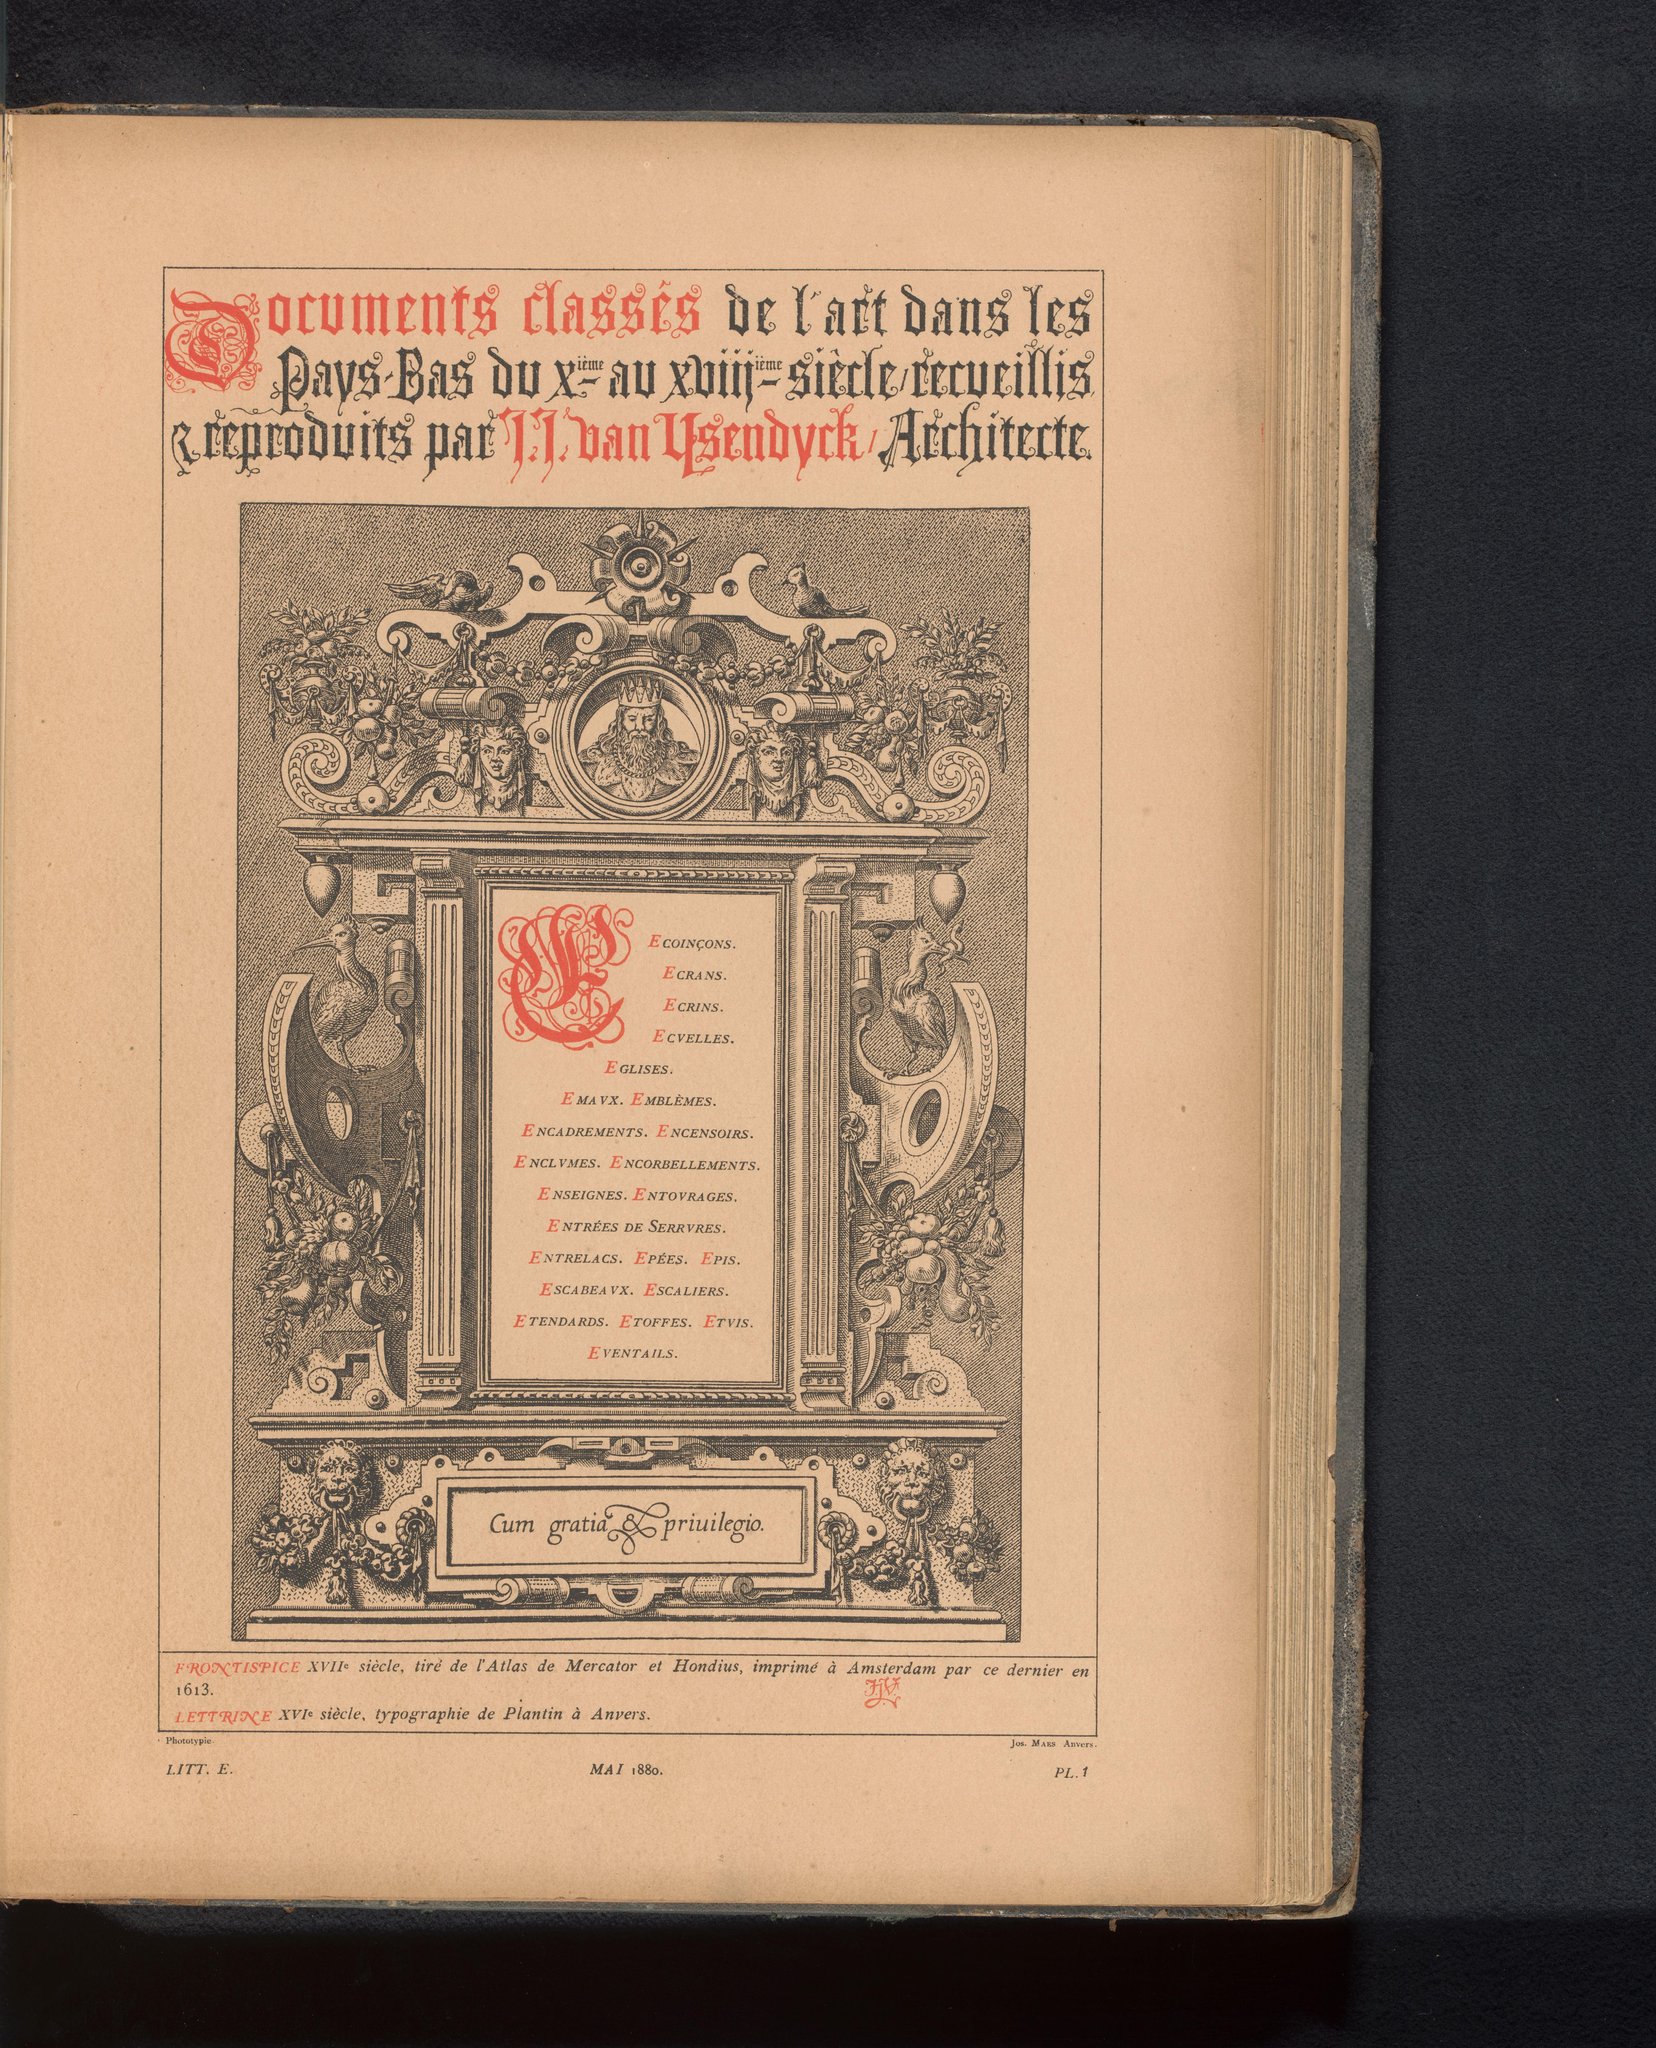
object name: page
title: Reproductie van een titelpagina met grotesken uit de atlas van Mercator en Hondius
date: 1875-1880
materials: paper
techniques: photolithography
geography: antwerp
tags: ornament ~ grotesque, title-page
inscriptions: inscription: ‘LITT. E. - MAI 1880. - PL. 1’, monogram: ‘JJvY’, inscription: ‘FRONTISPICE XVIIe siècle (...)’